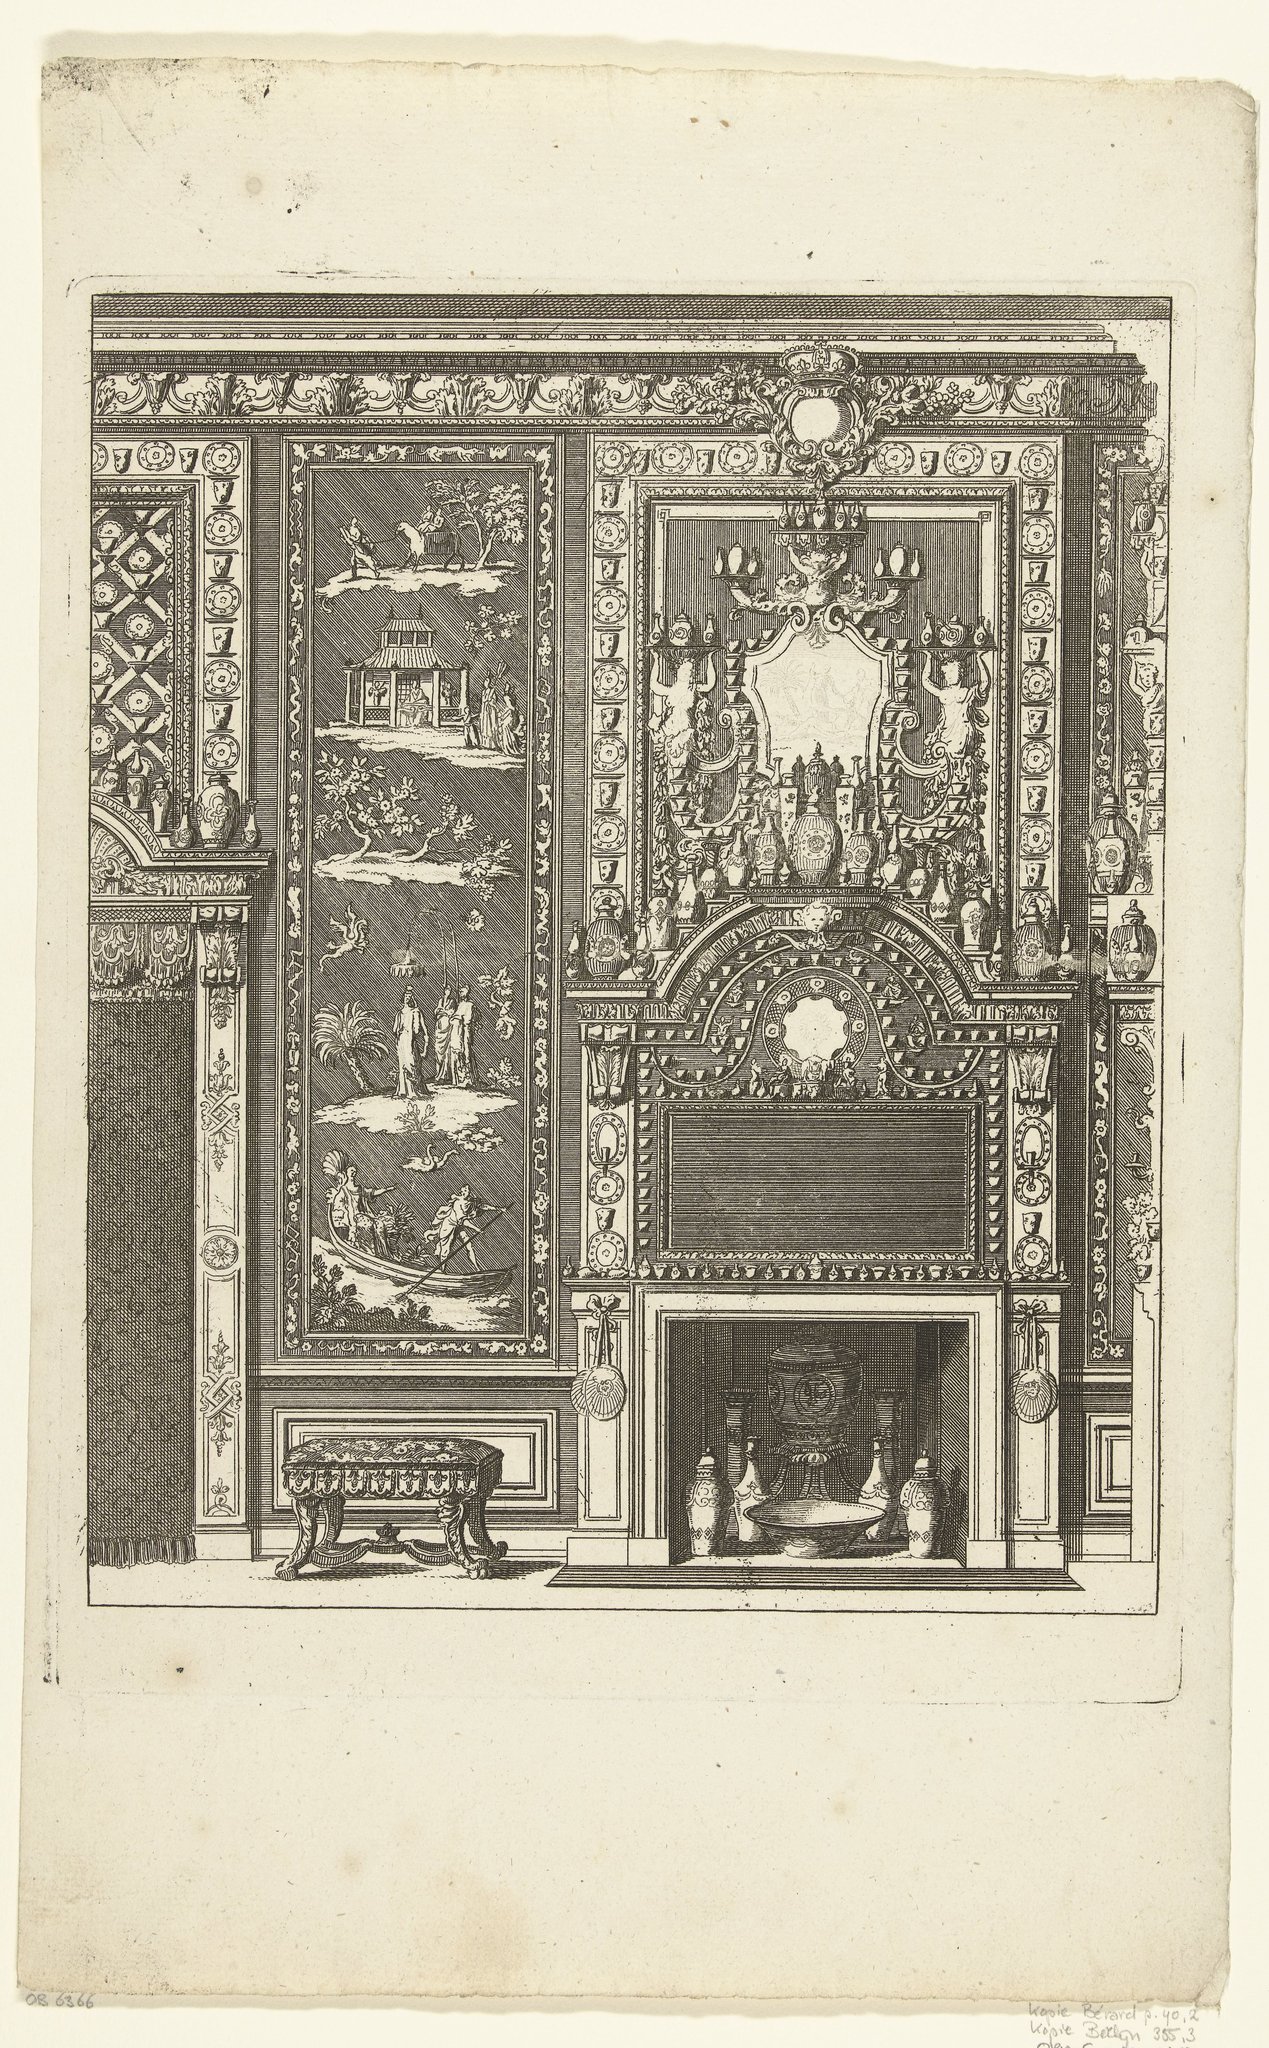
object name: ornament print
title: Schouw voor een wand met lakwerk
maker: Anonymous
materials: paper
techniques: etching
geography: netherlands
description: Een schouw voor een wand met lakwerk. Links de helft van een deur met dessus-de-porte. Op de schouw en de kroonlijst van de deur staat een groot aantal Chinese porseleinen vazen. Kopie naar prent uit de serie Nouvelles Cheminée faittes en plusieur en droits de la Hollande et autres Prouinces.